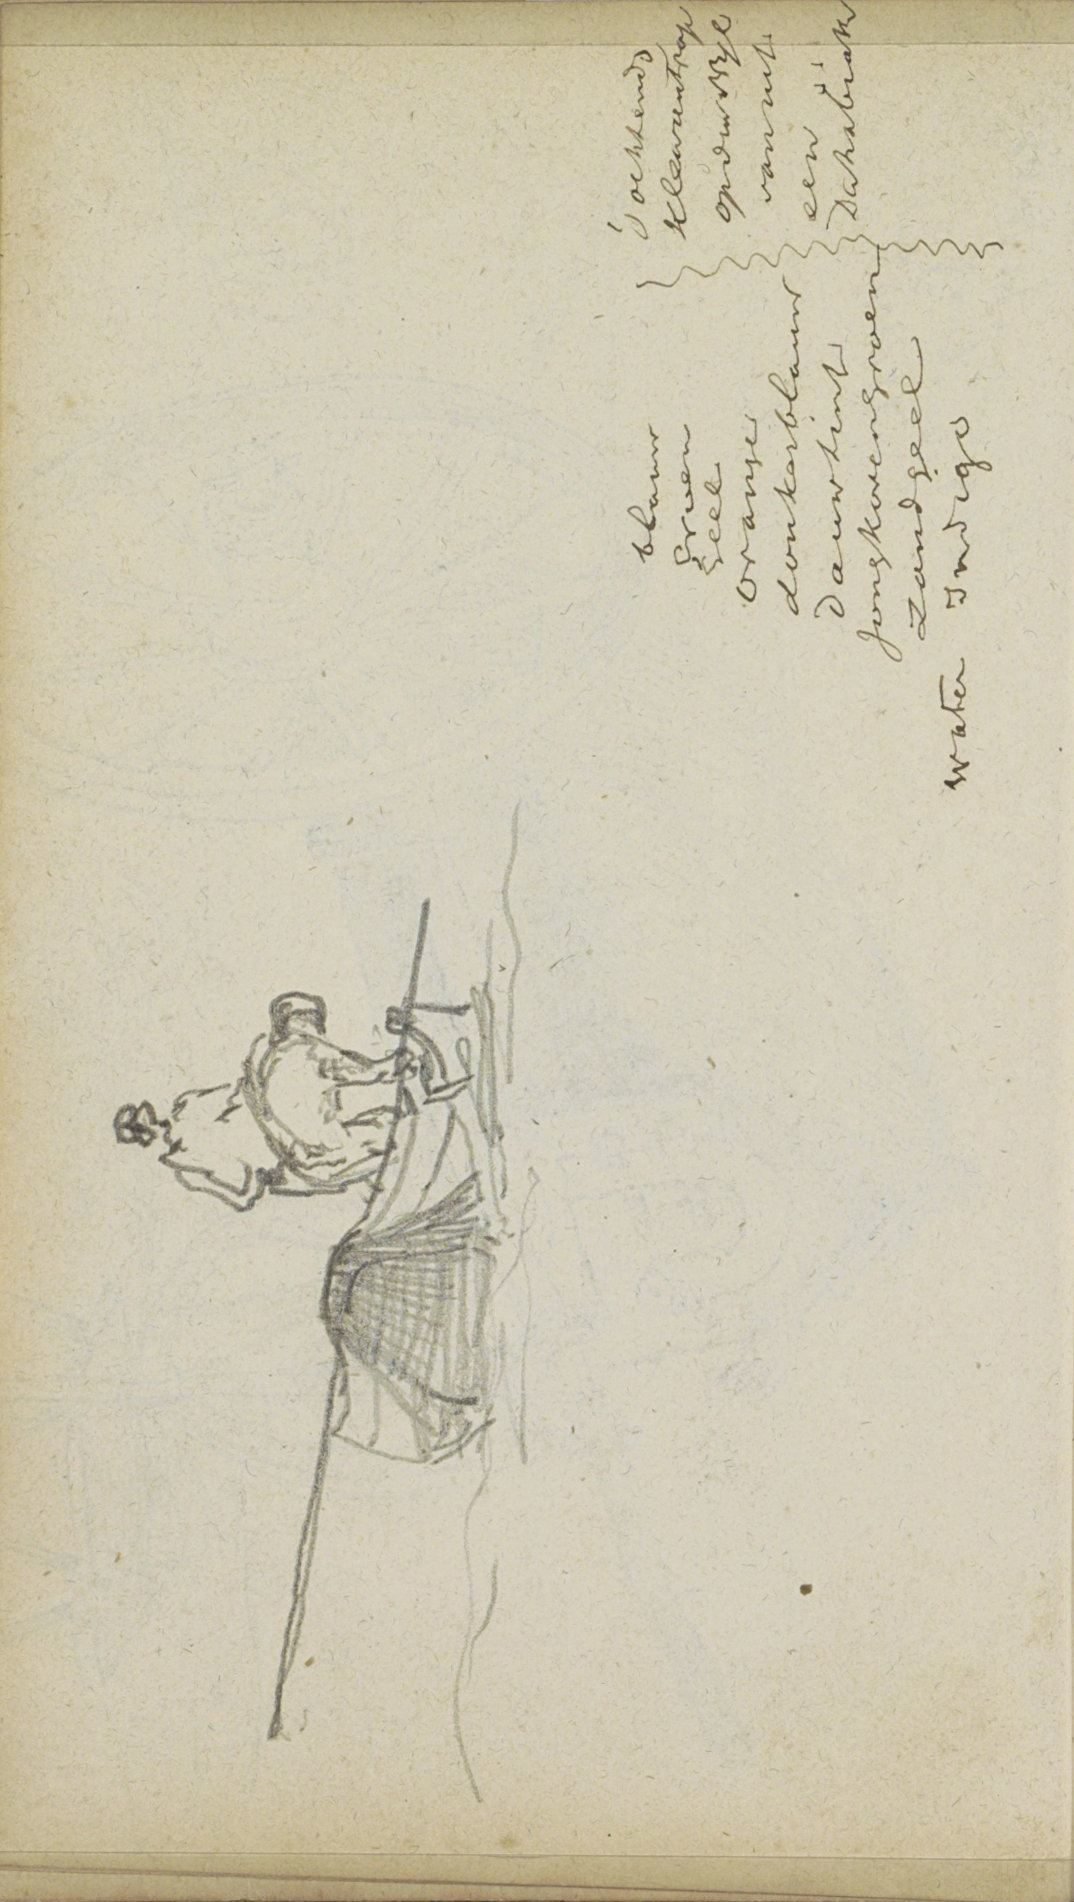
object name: sketchbook leaf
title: Twee mannen in een roeiboot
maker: johannes tavenraat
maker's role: draughtsman, painter, print maker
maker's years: 1809-1881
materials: ink, paper, pencil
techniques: pen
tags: adult man, rowing-boat, canoe, etc.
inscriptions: annotation: ‘[...]’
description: Blad 9 verso uit een schetsboek met 88 bladen.